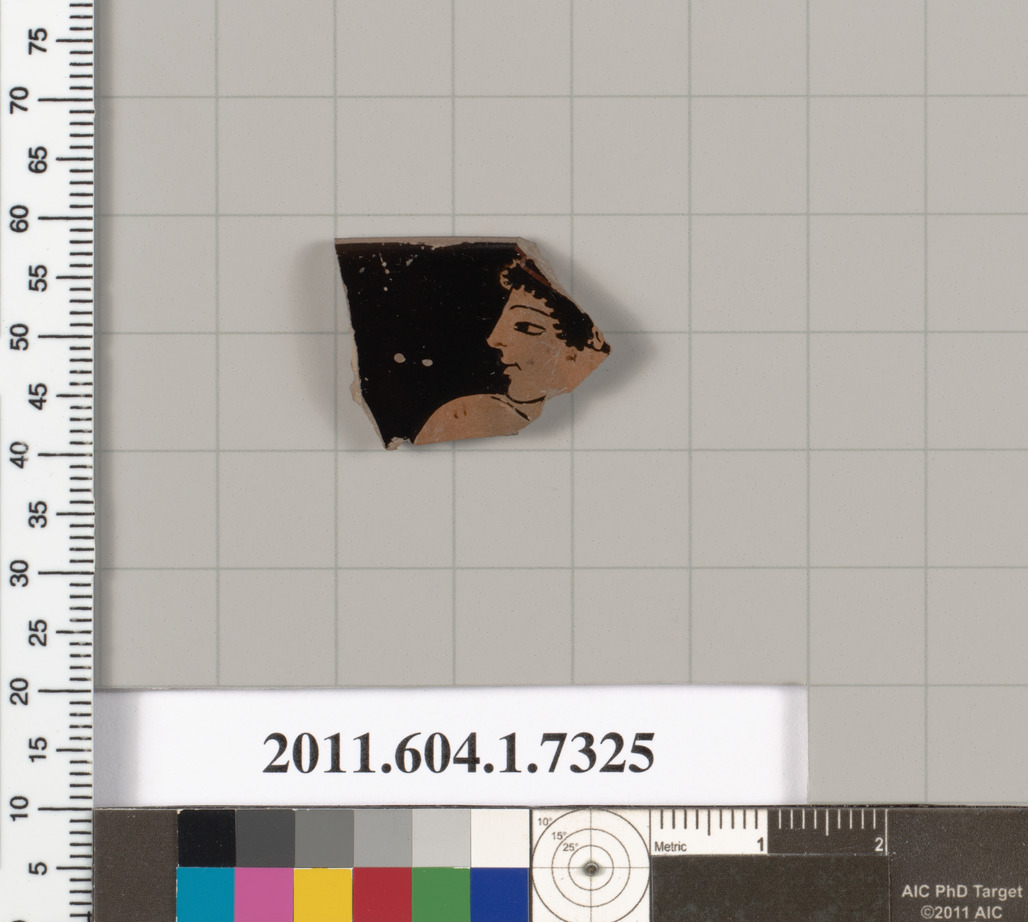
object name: kylix fragment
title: Terracotta rim fragment of a kylix (drinking cup)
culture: greek, attic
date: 500-480 BCE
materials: terracotta